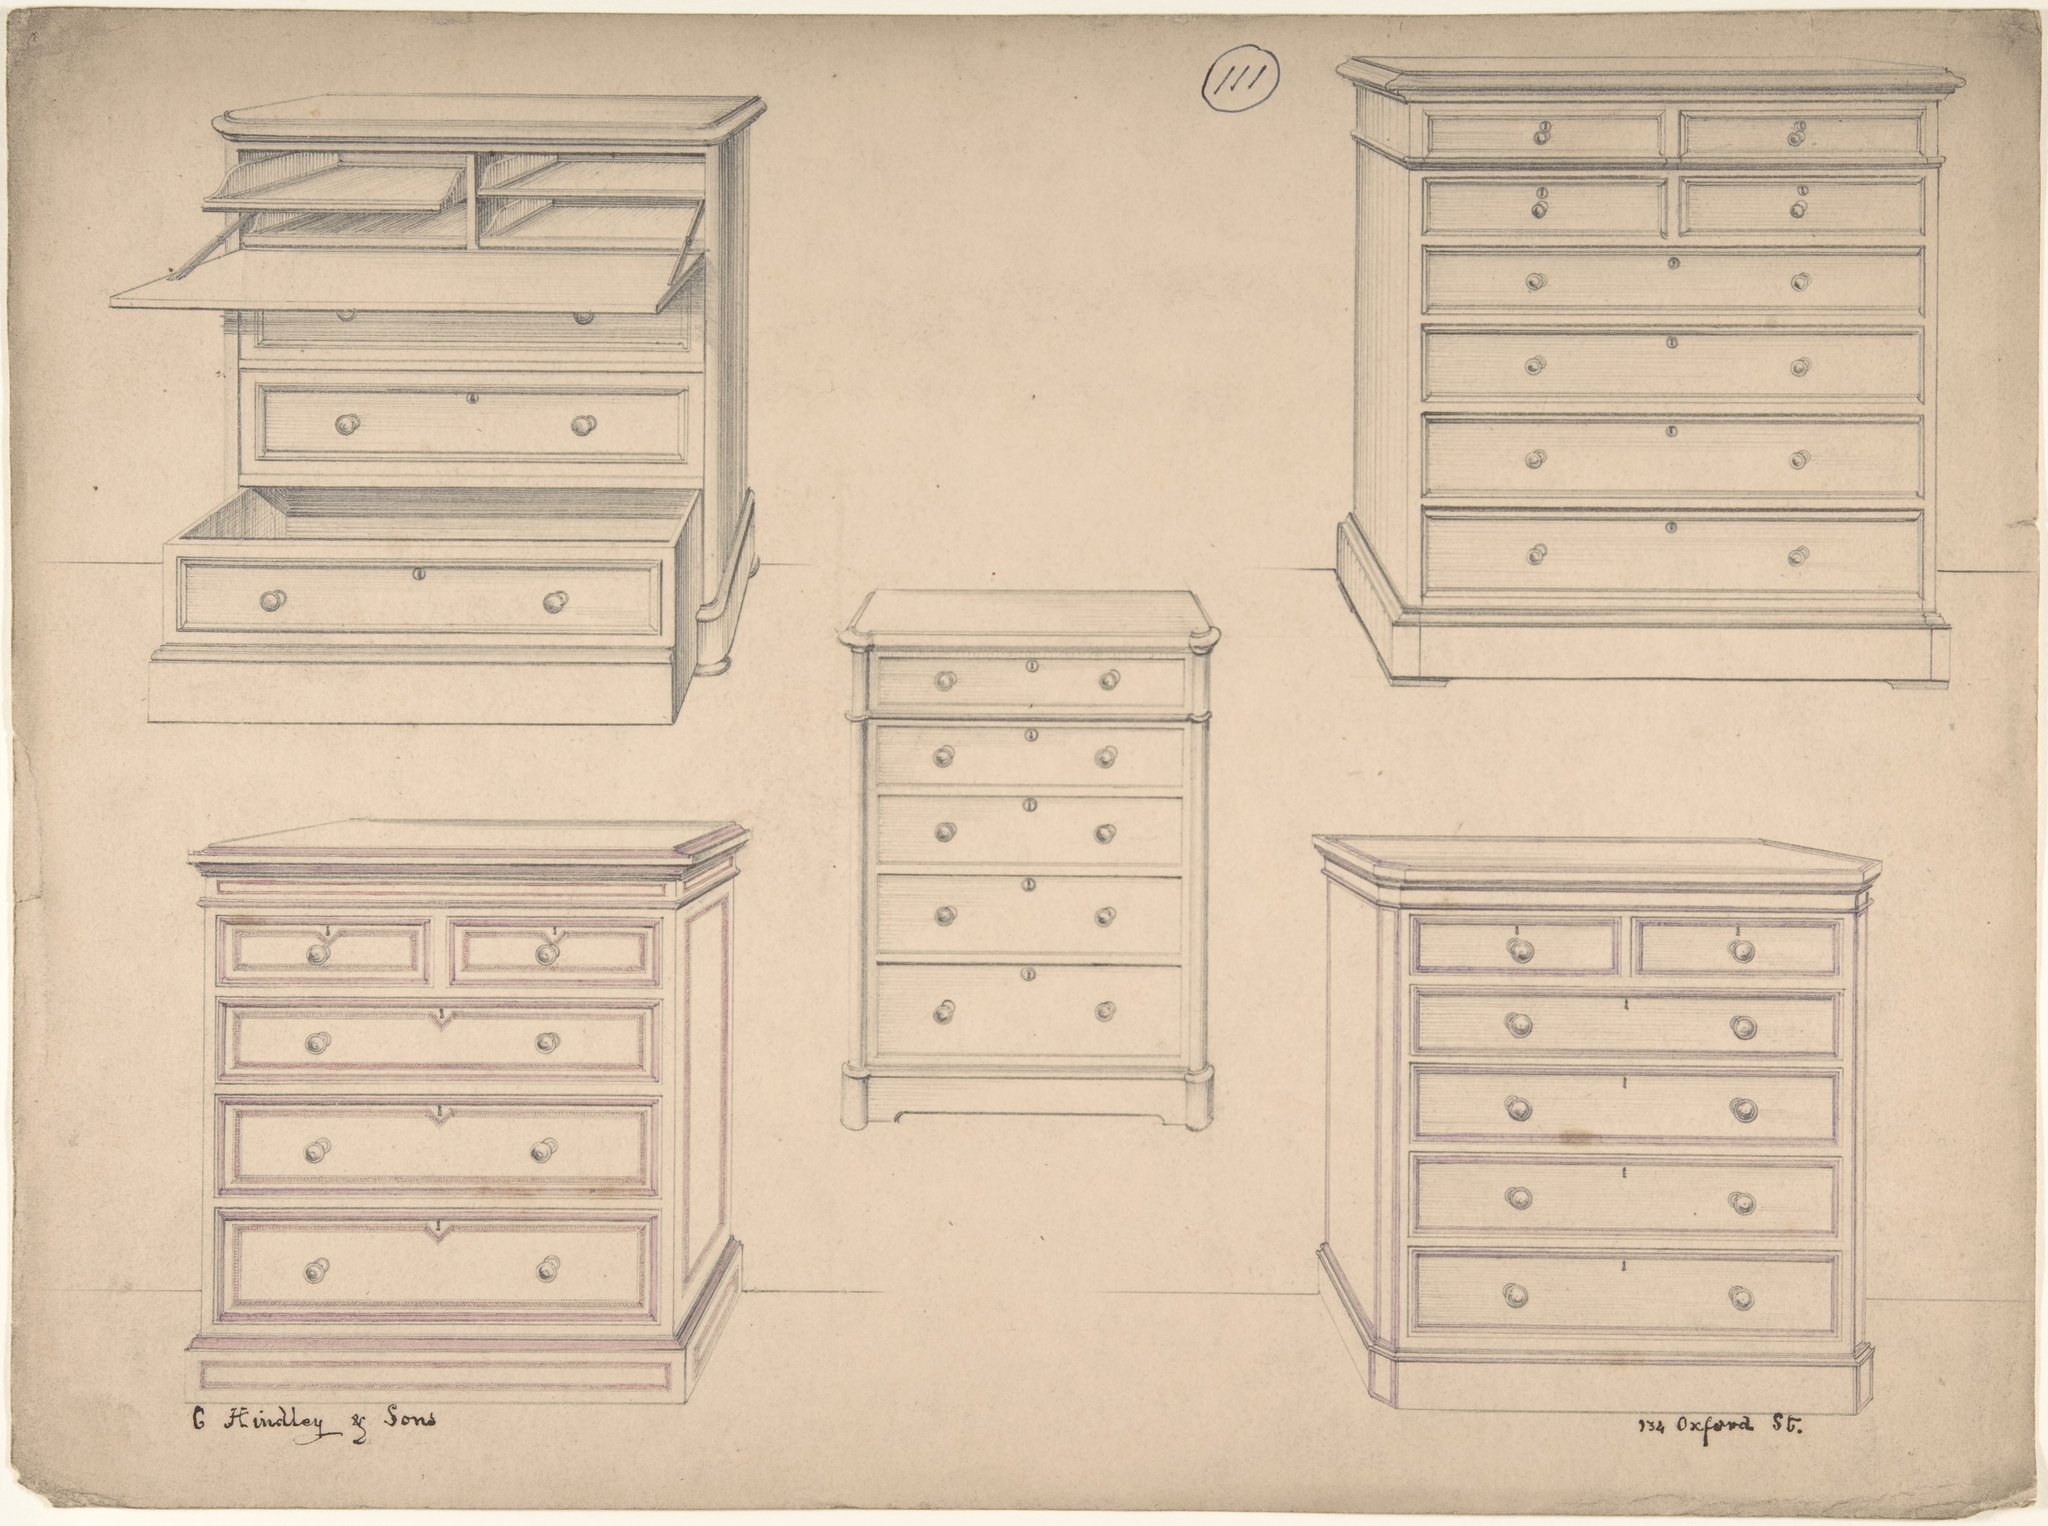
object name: drawing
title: Designs for Chests of Drawers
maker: charles hindley and sons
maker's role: artist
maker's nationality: british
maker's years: 1841-1917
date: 1841-1884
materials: graphite, watercolor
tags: chests